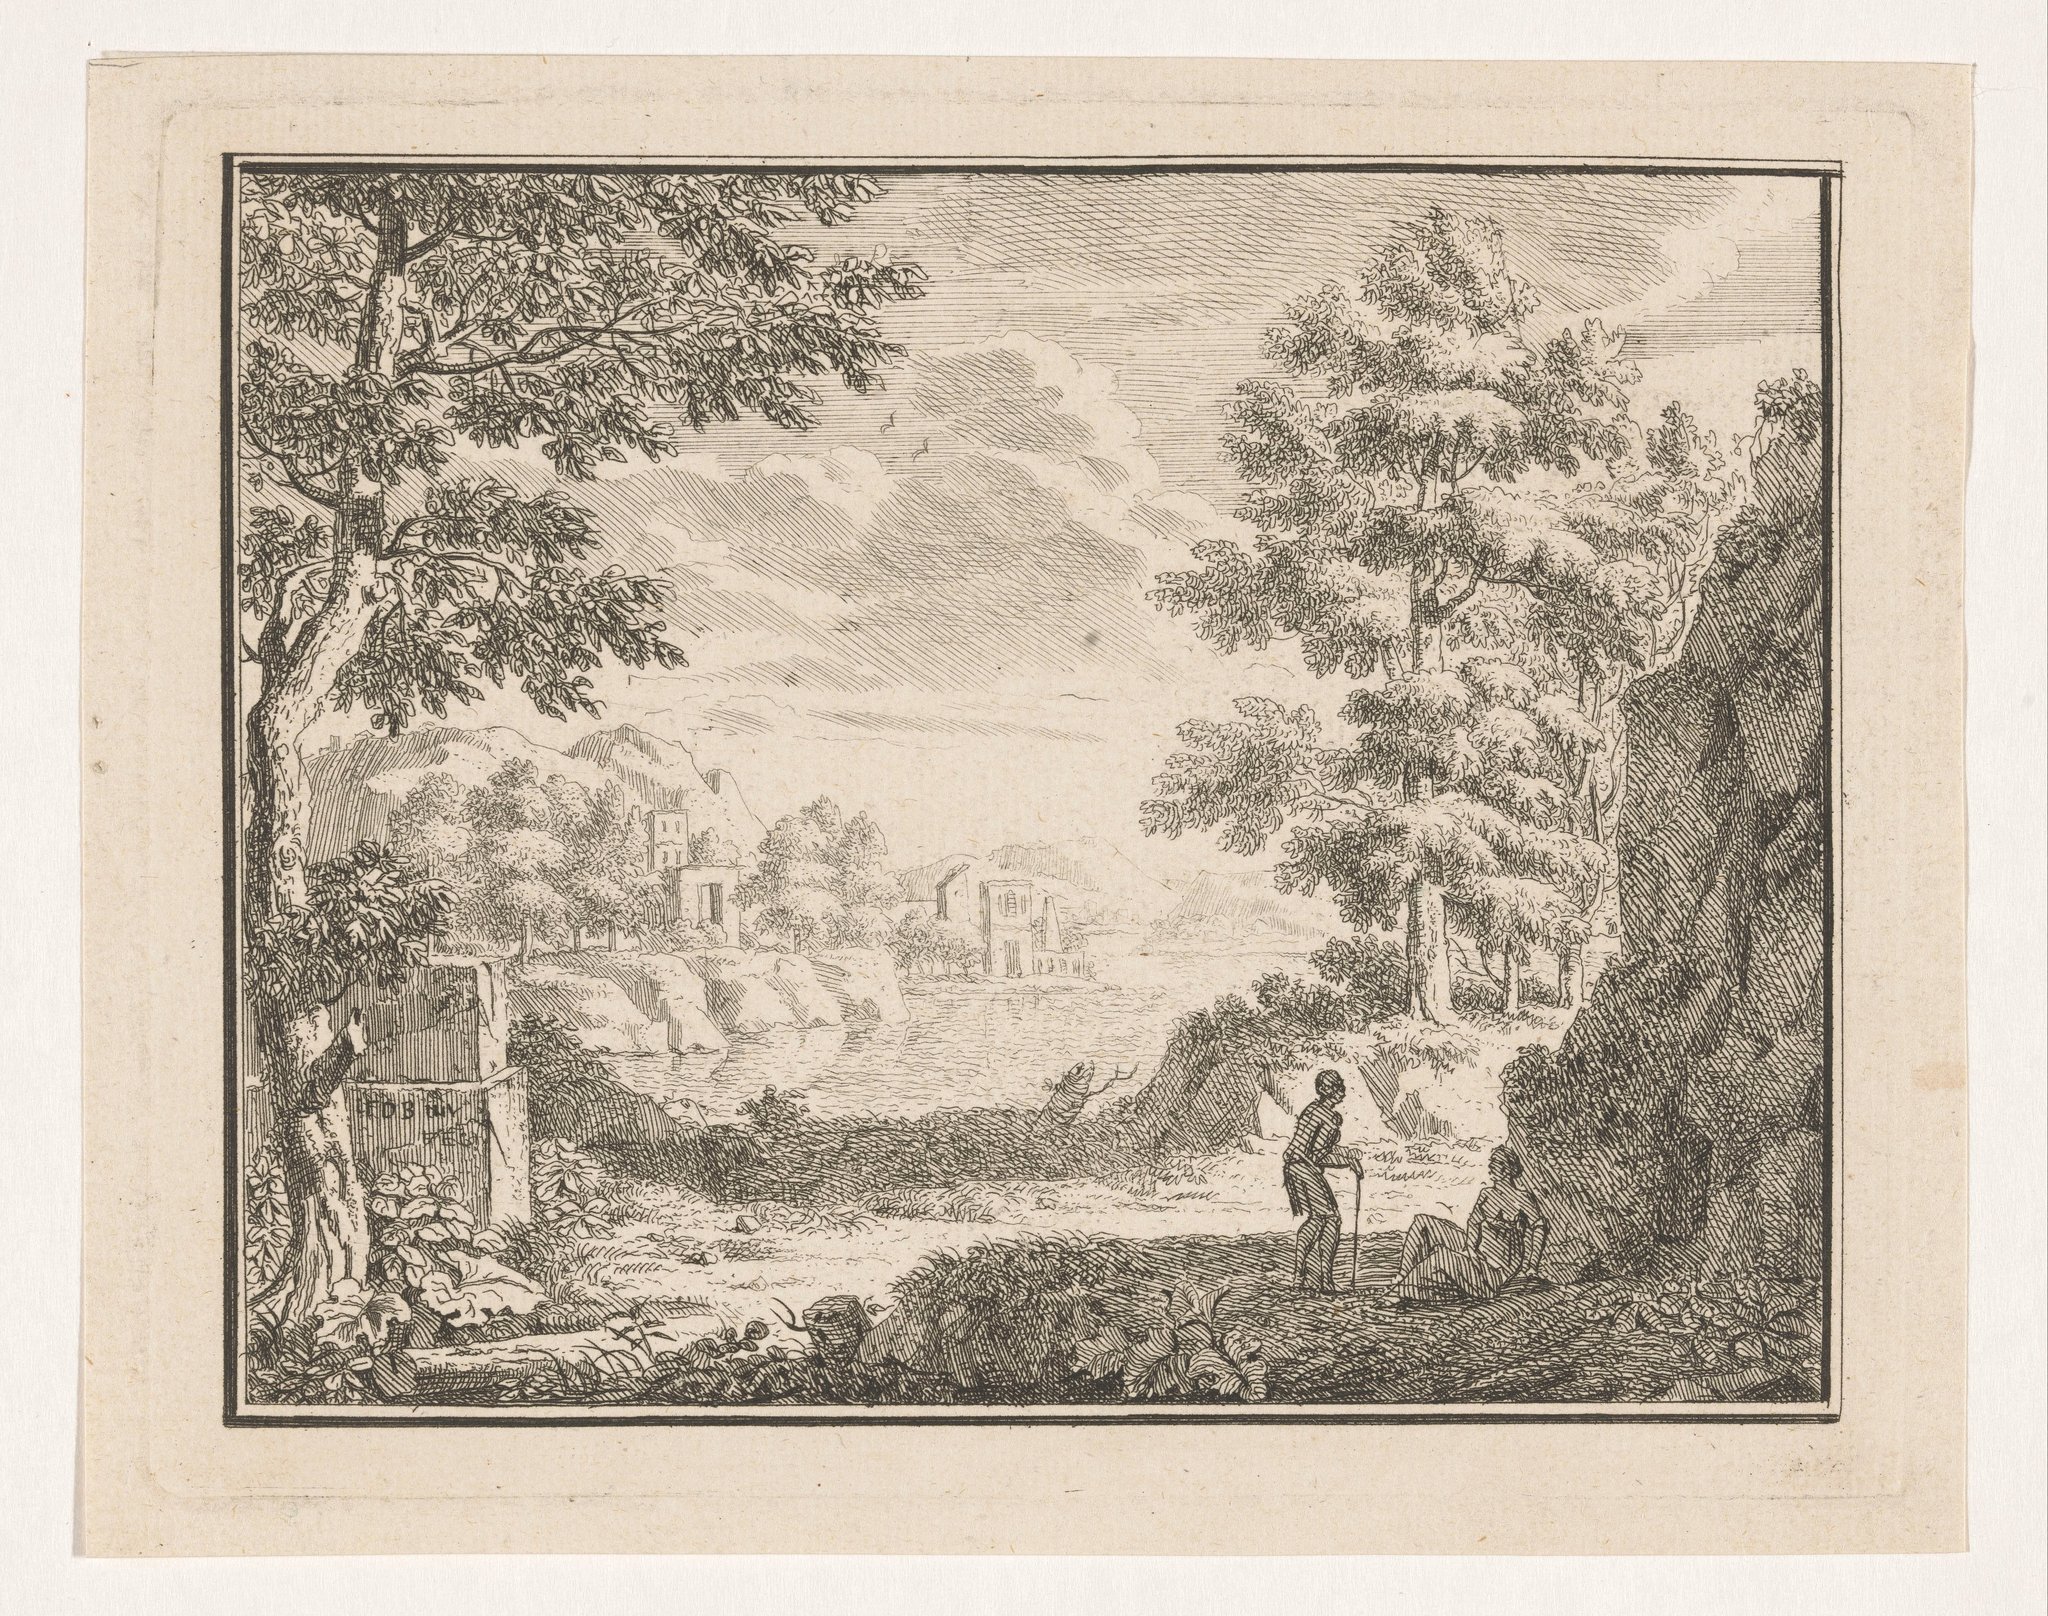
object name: print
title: Arcadisch landschap met twee in de schaduw rustende reizigers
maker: louis fabritius dubourg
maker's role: draughtsman, print maker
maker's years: 1693-1775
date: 1713-1775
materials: paper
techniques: etching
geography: amsterdam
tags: (traveller) resting in the open air, pastorals, arcadian scenes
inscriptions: collector's mark: Lugt 240